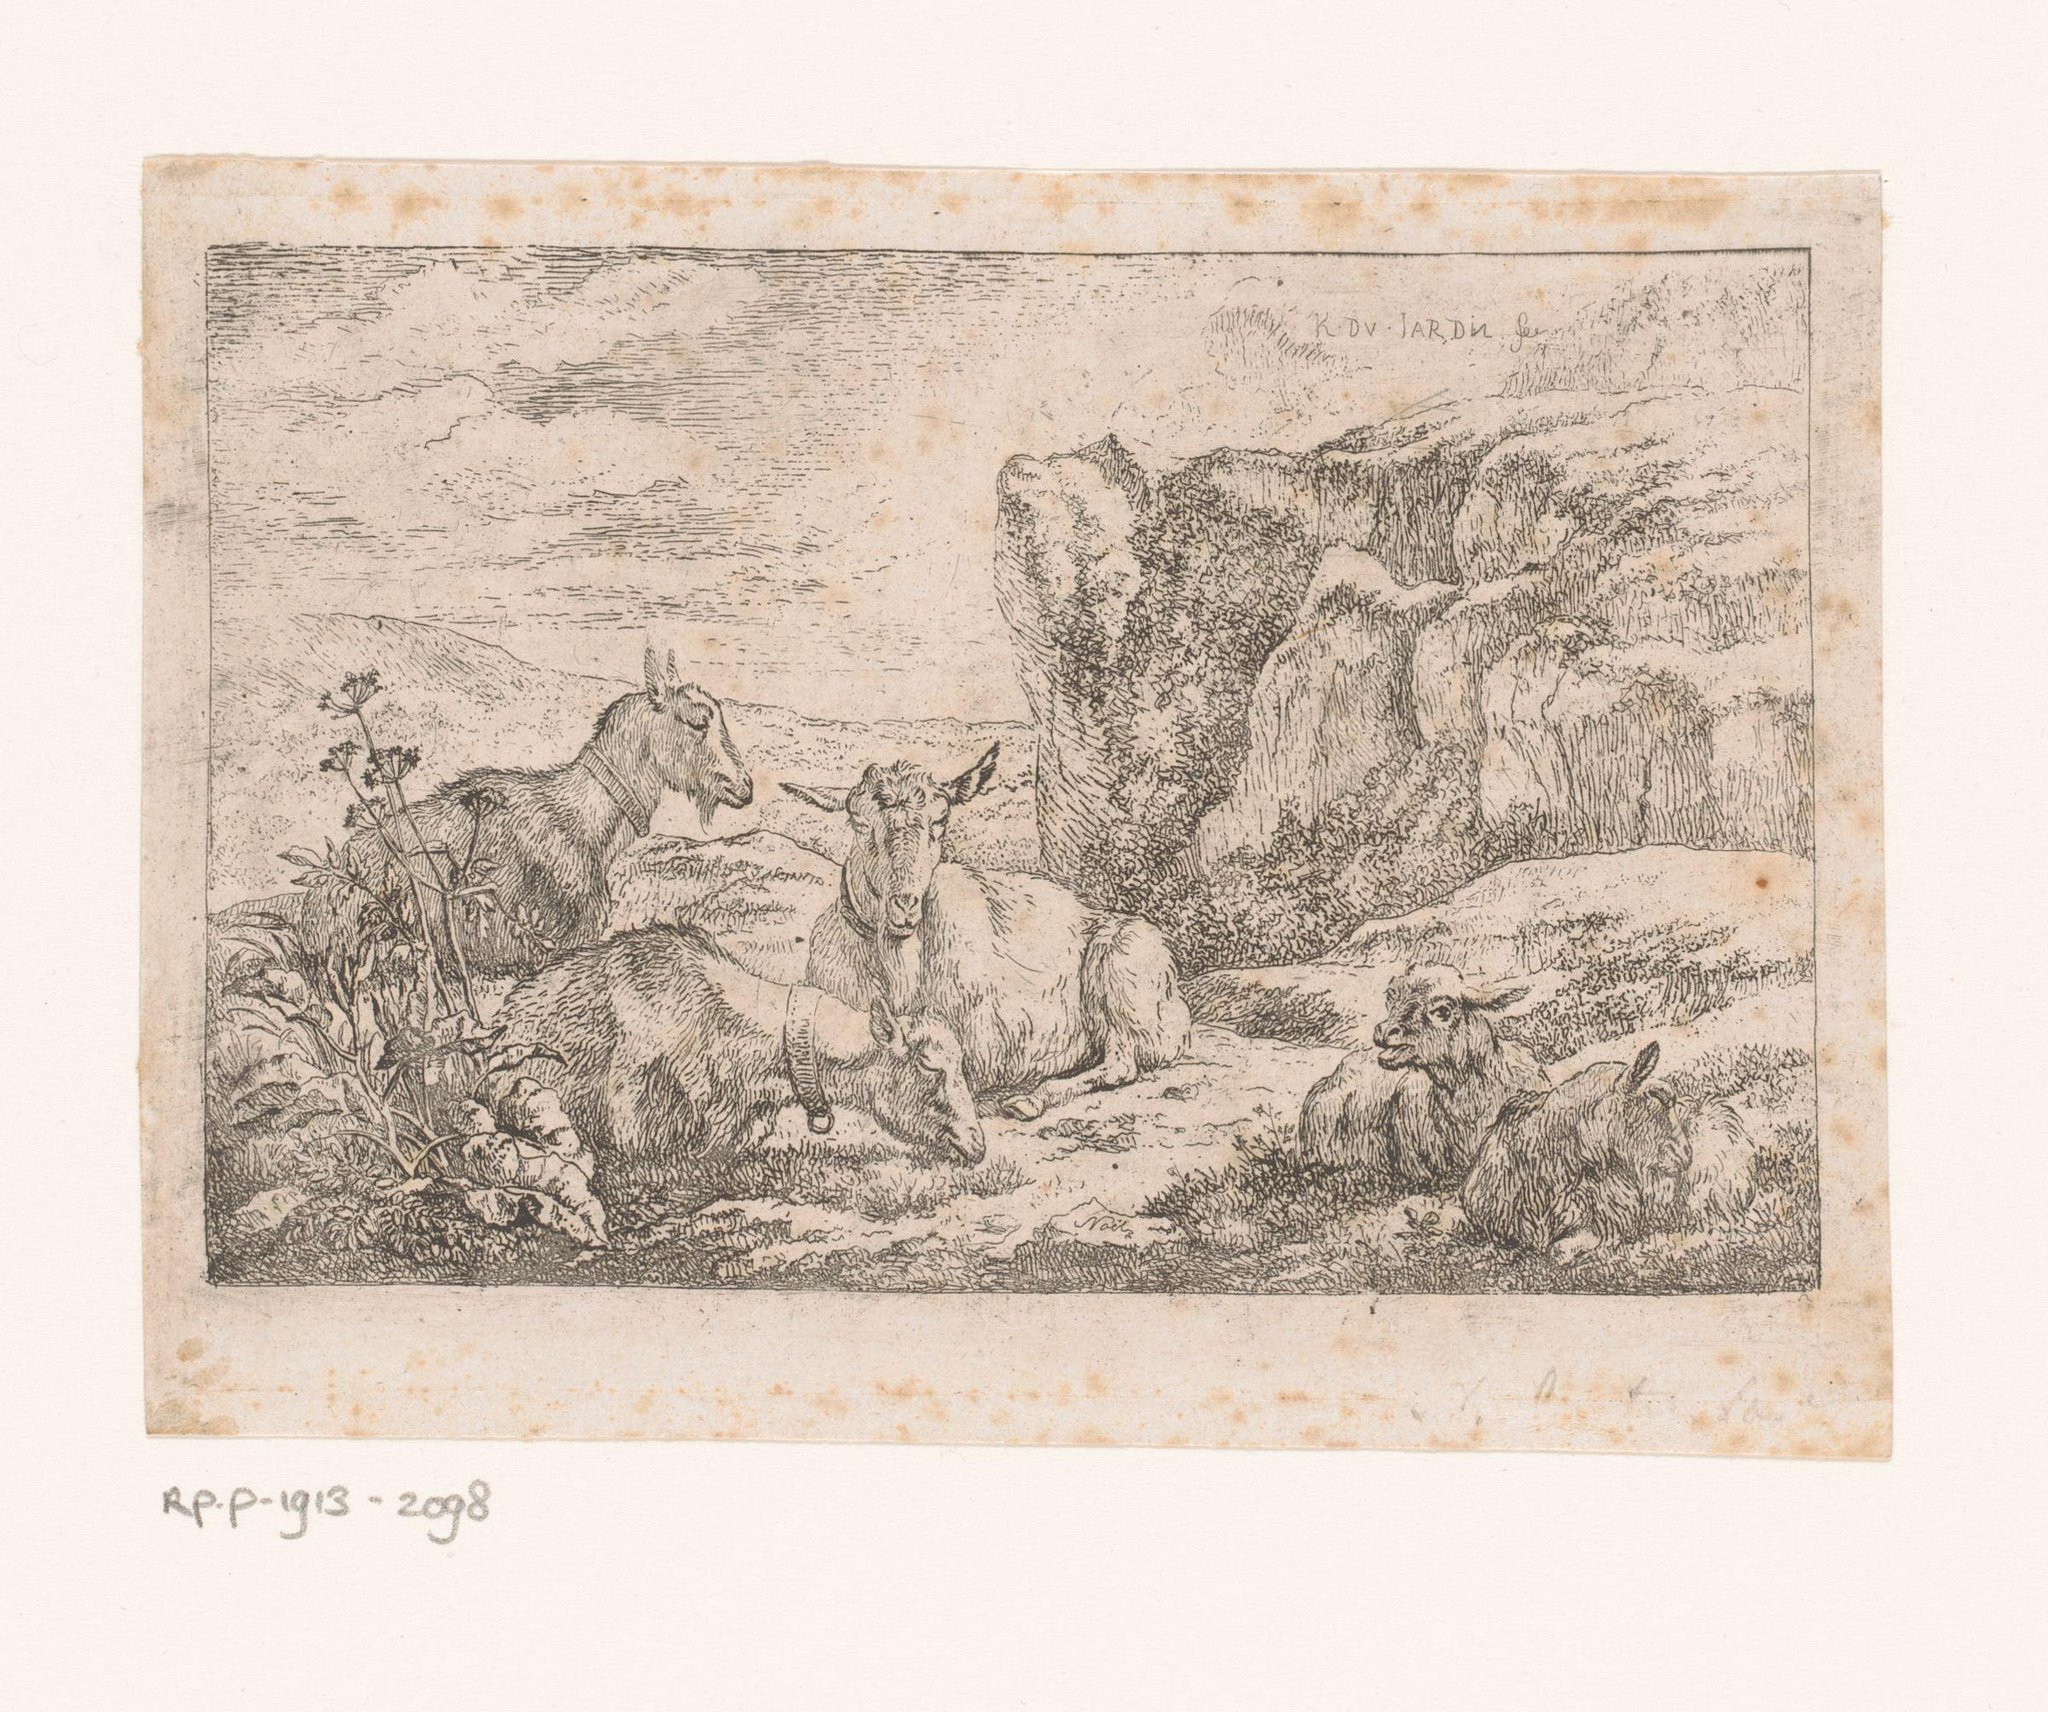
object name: print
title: Landschap met geiten en lammeren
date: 1799-1822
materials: paper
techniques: etching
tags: lamb, goat, rocks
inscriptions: collector's mark: Lugt 2228, collector's mark: Lugt 1485